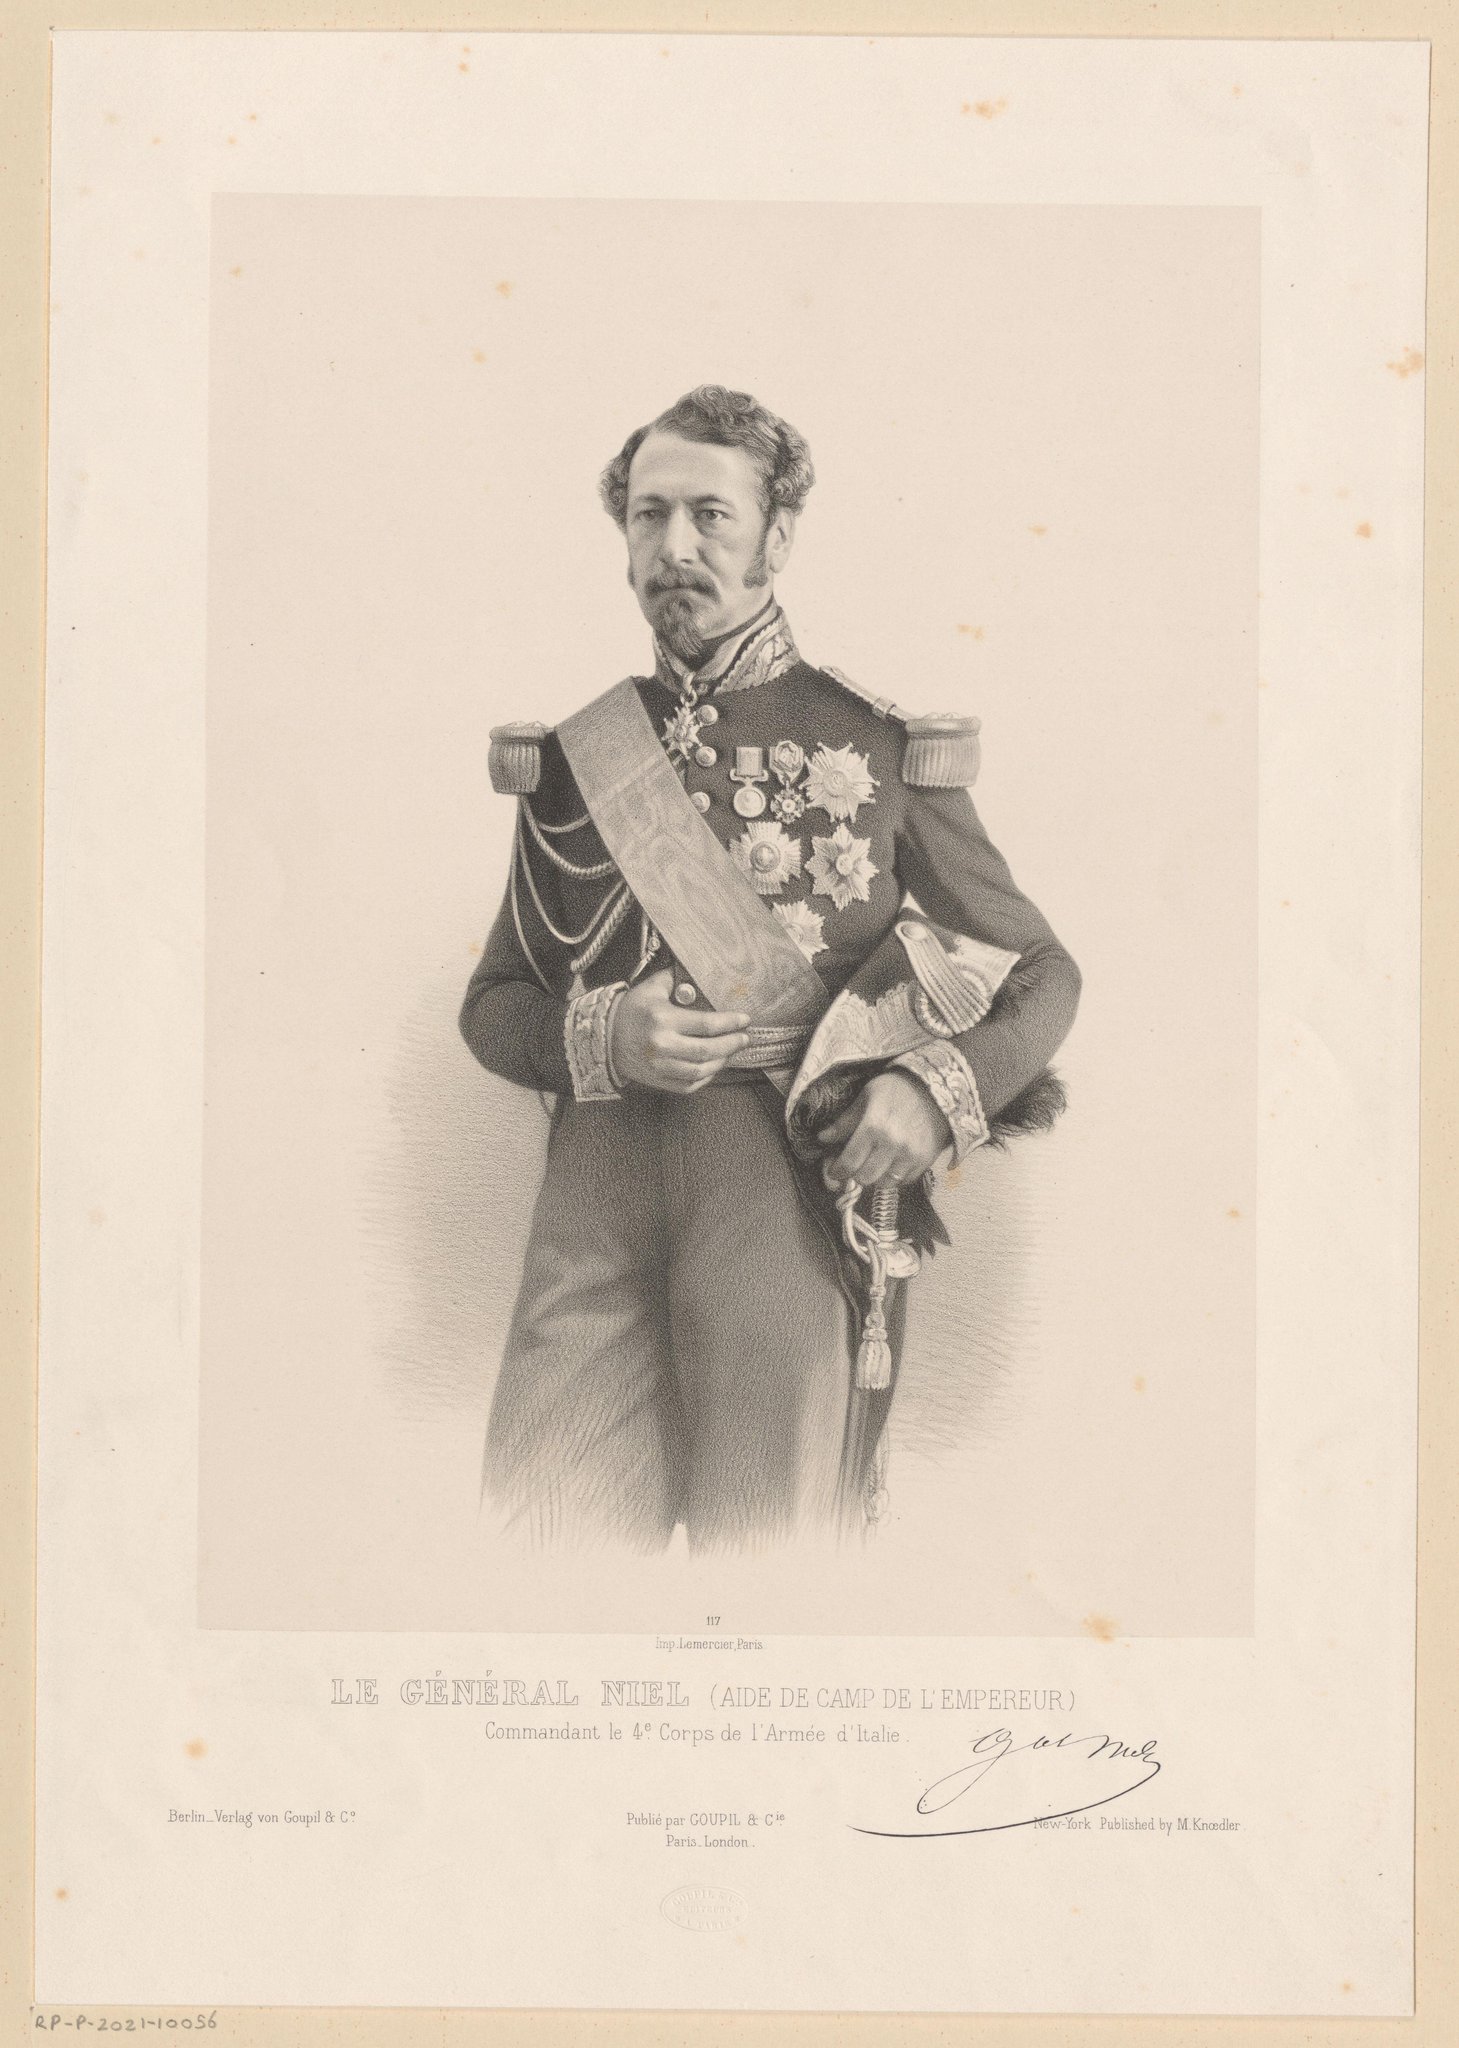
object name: print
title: Portret van Adolphe Niel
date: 1850-1878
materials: paper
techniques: lithograph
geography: london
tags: commander-in-chief, general, marshal, historical persons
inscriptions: check stamp: Lugt 1090